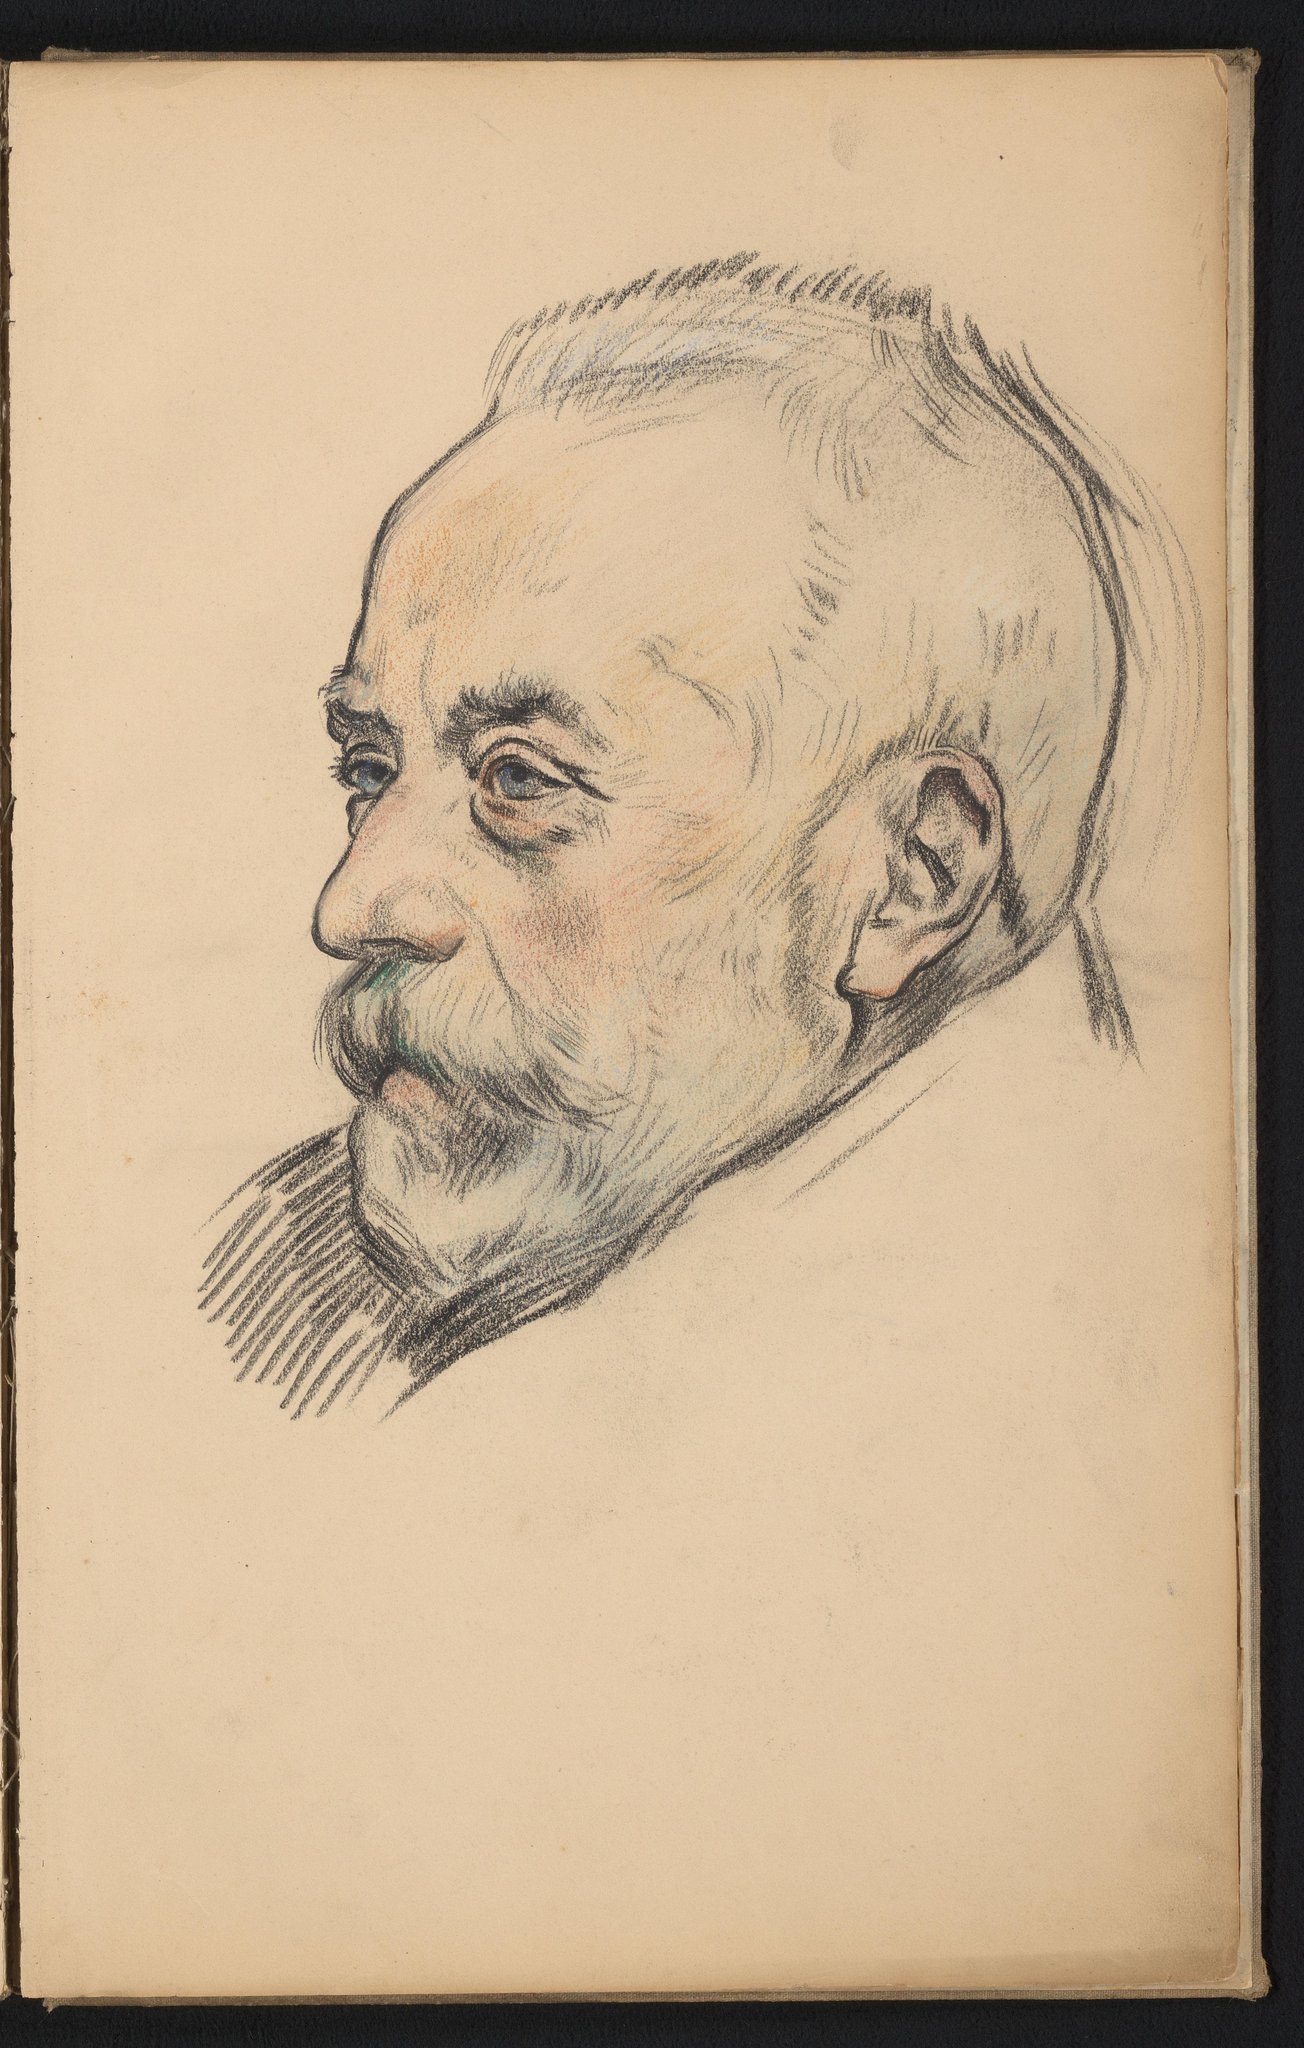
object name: sketchbook leaf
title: Portret van een man met een snor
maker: huib luns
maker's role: draughtsman, print maker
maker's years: 1881-1942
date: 1908-1909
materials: chalk, paper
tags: moustache, anonymous historical person portrayed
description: Blad 2 verso uit een schetsboek met 24 bladen.